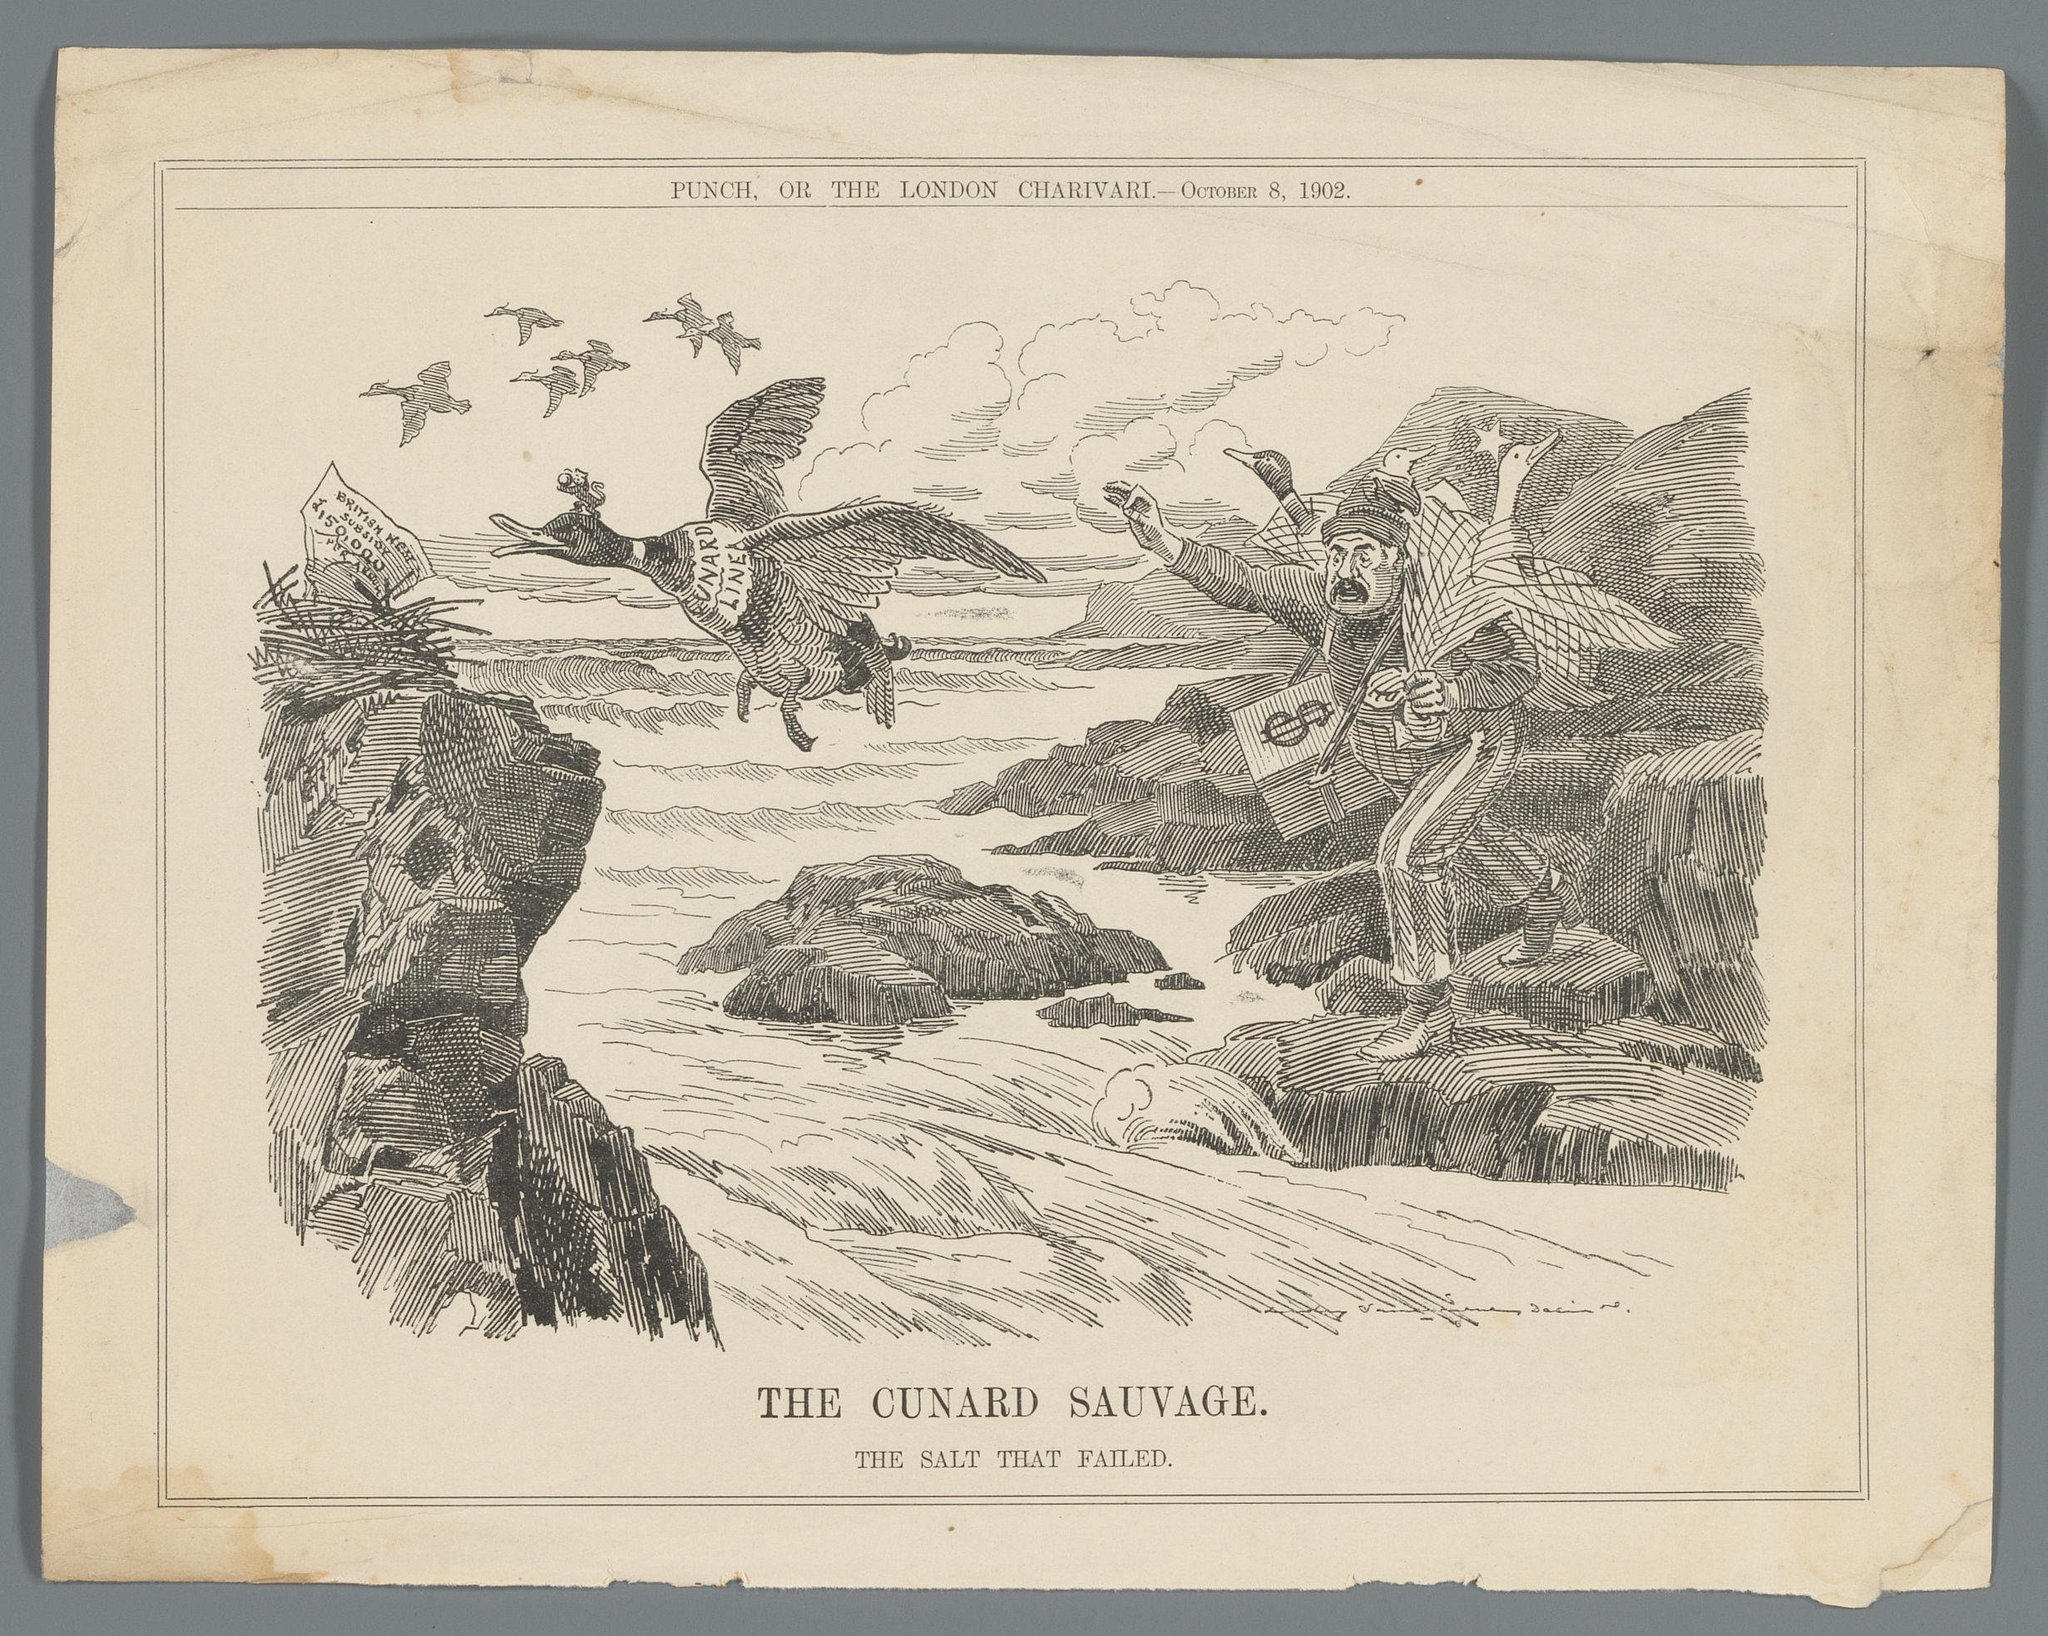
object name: cartoon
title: Spotprent over de Cunard Line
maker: edward linley sambourne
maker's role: draughtsman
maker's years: 1844-1910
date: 1902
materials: paper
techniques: line block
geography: england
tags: catching animals, water-birds: duck, political caricatures and satires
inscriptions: date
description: Spotprent over de Cunard Line. Een man probeert tevergeefs met Amerikaanse dollars eenden van de Cunard Line te lokken en te vangen. Spotprent in het Engelse satirische tijdschrift Punch, 8 oktober 1902.